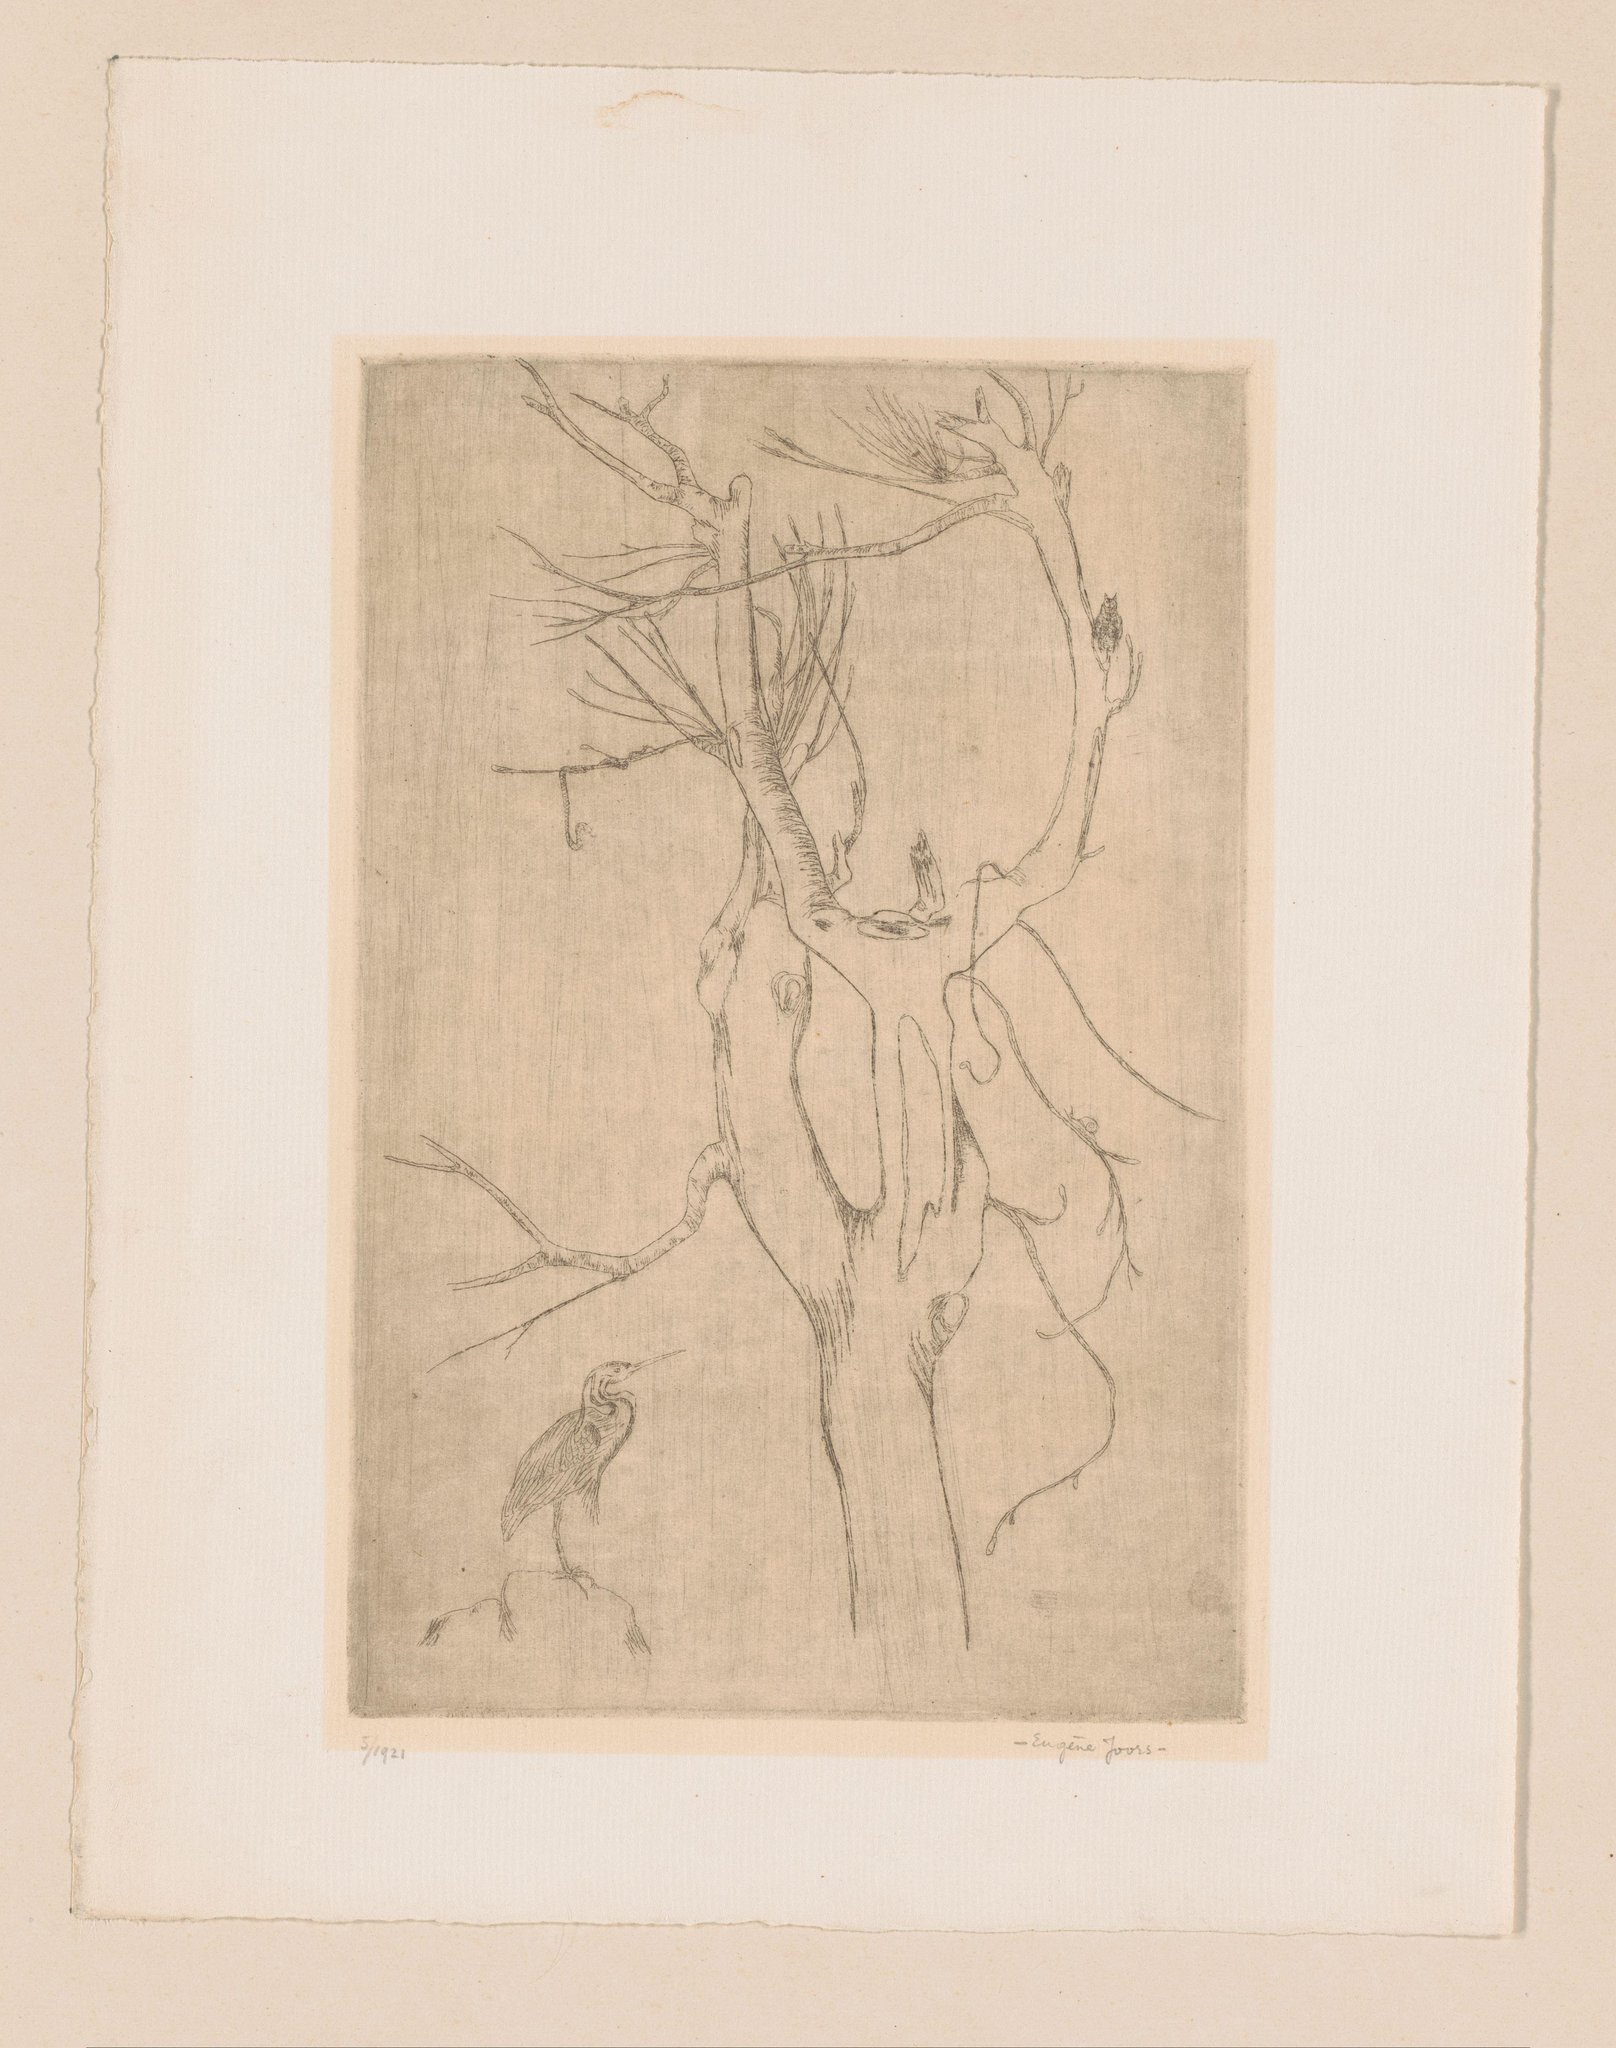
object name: print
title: Boom en reiger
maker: eugène joors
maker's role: painter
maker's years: 1850-1910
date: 1860-1910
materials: paper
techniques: drypoint, etching, intaglio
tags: trees, shore-birds and wading-birds: heron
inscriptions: annotation: ‘5/1921’, collector's mark: Lugt 2228